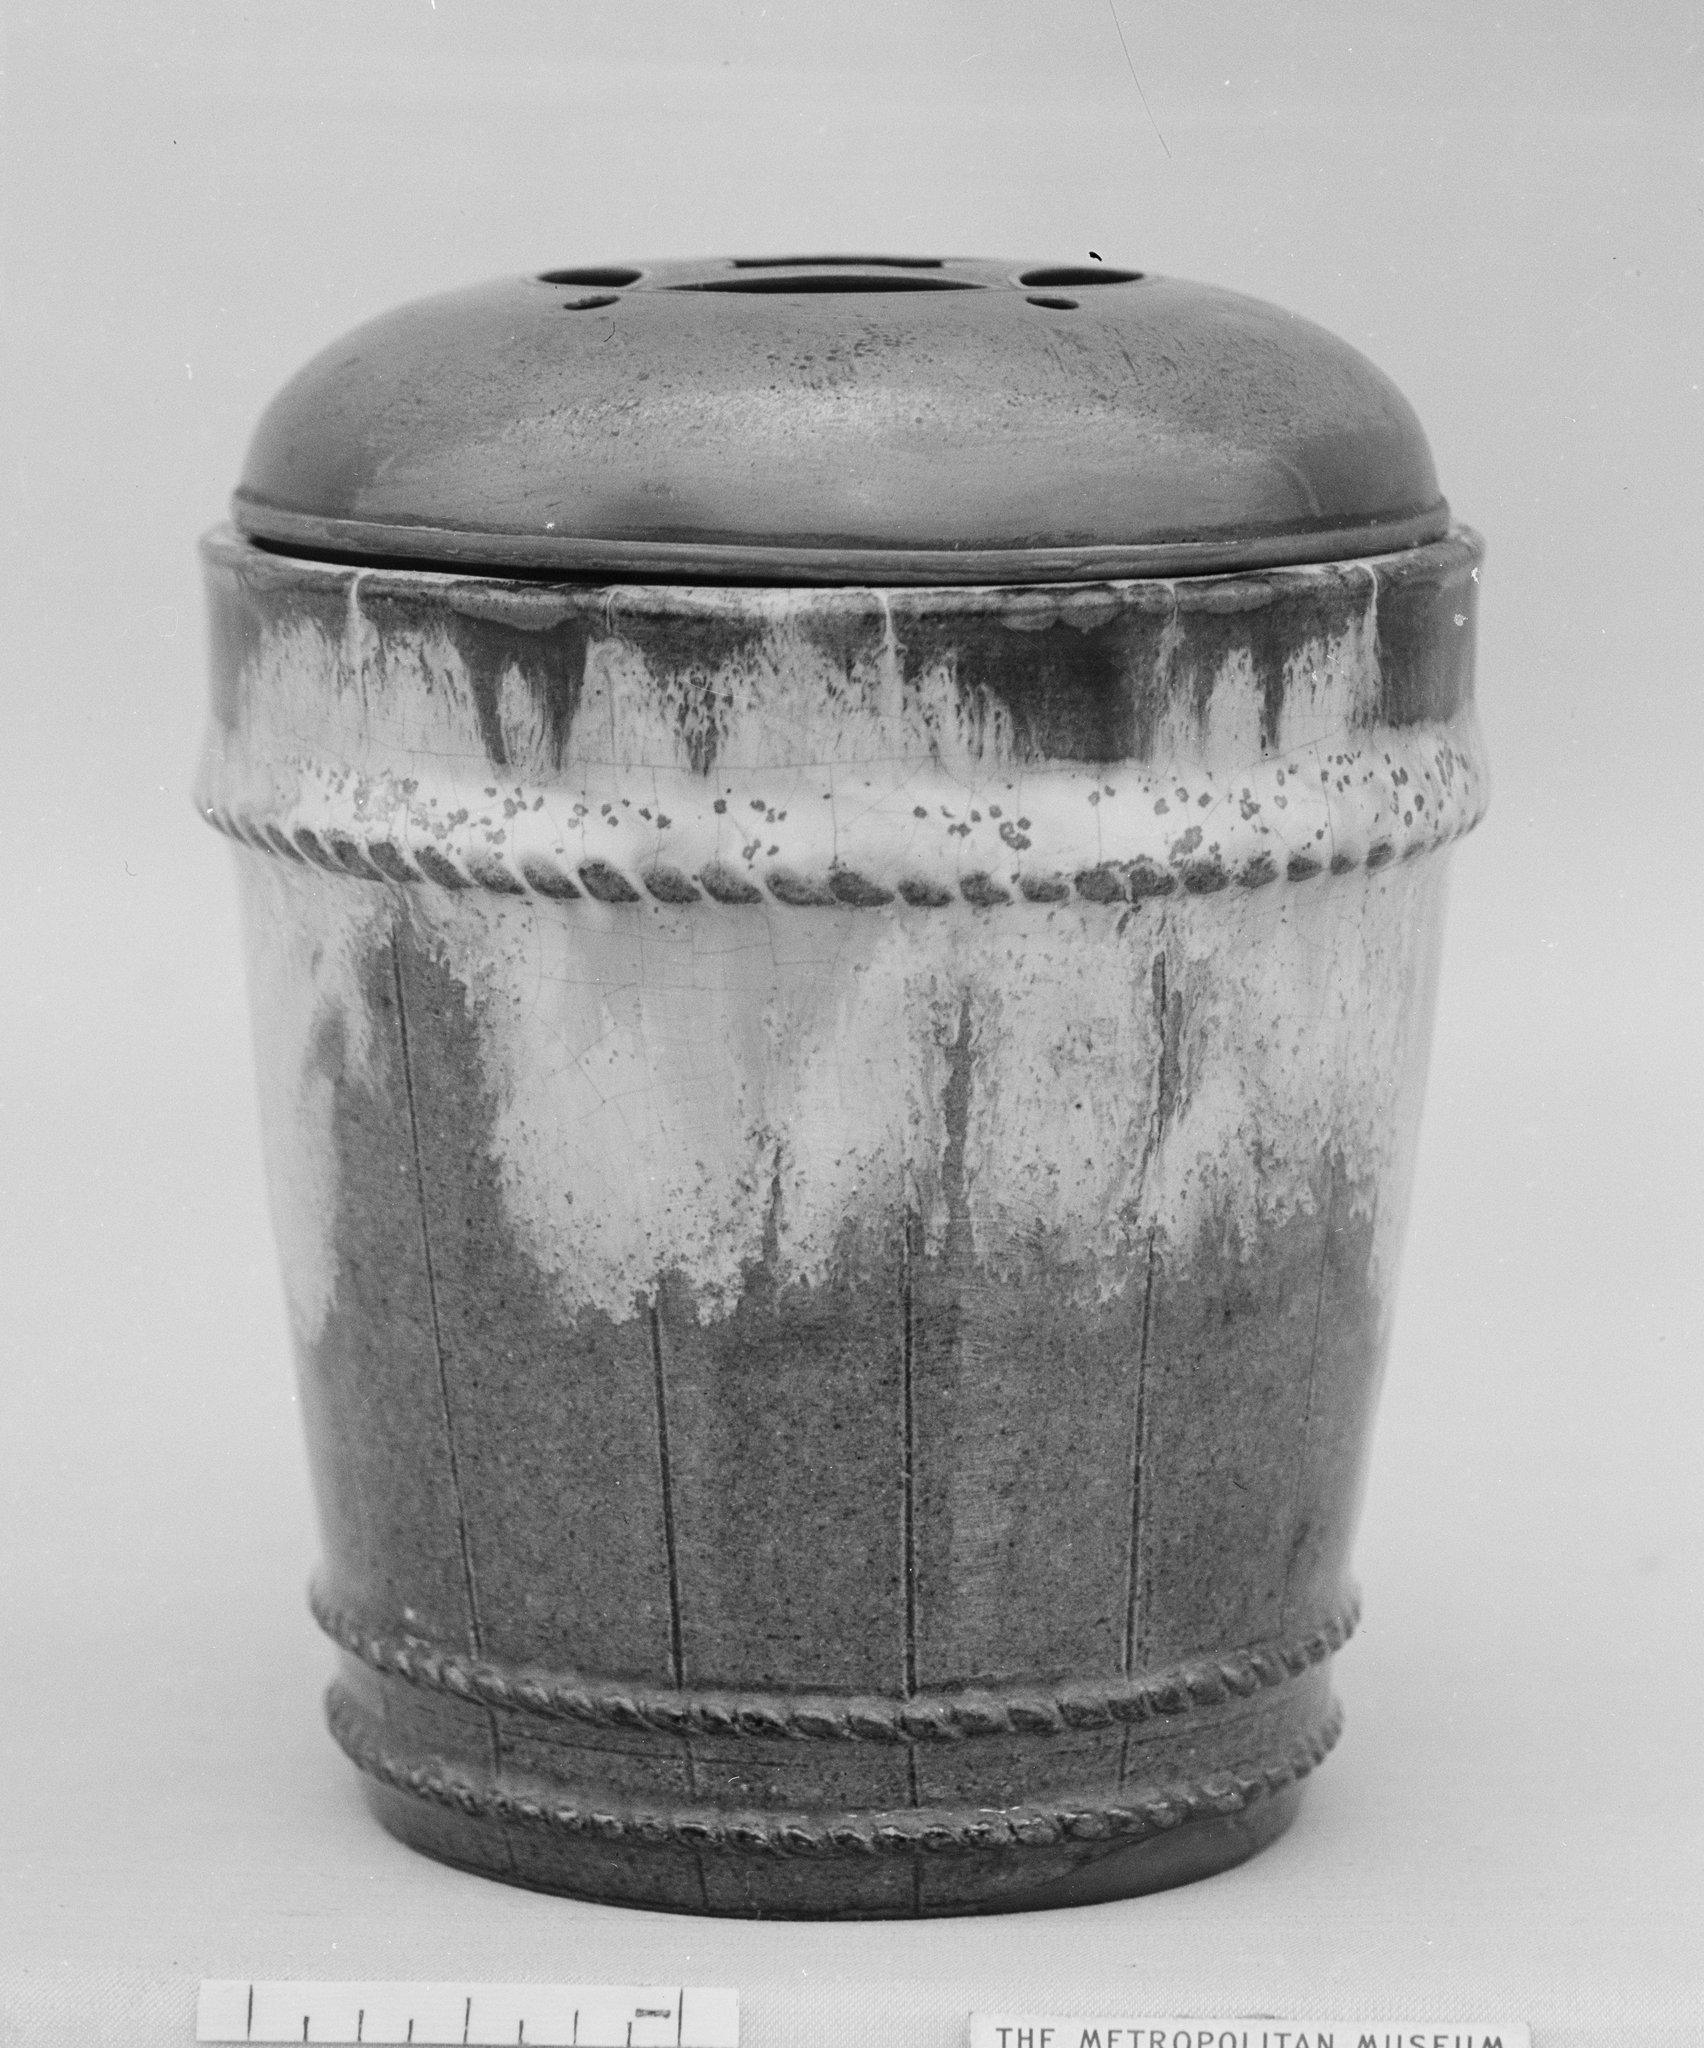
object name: incense burner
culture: japanese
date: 1801-1900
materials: clay, glaze